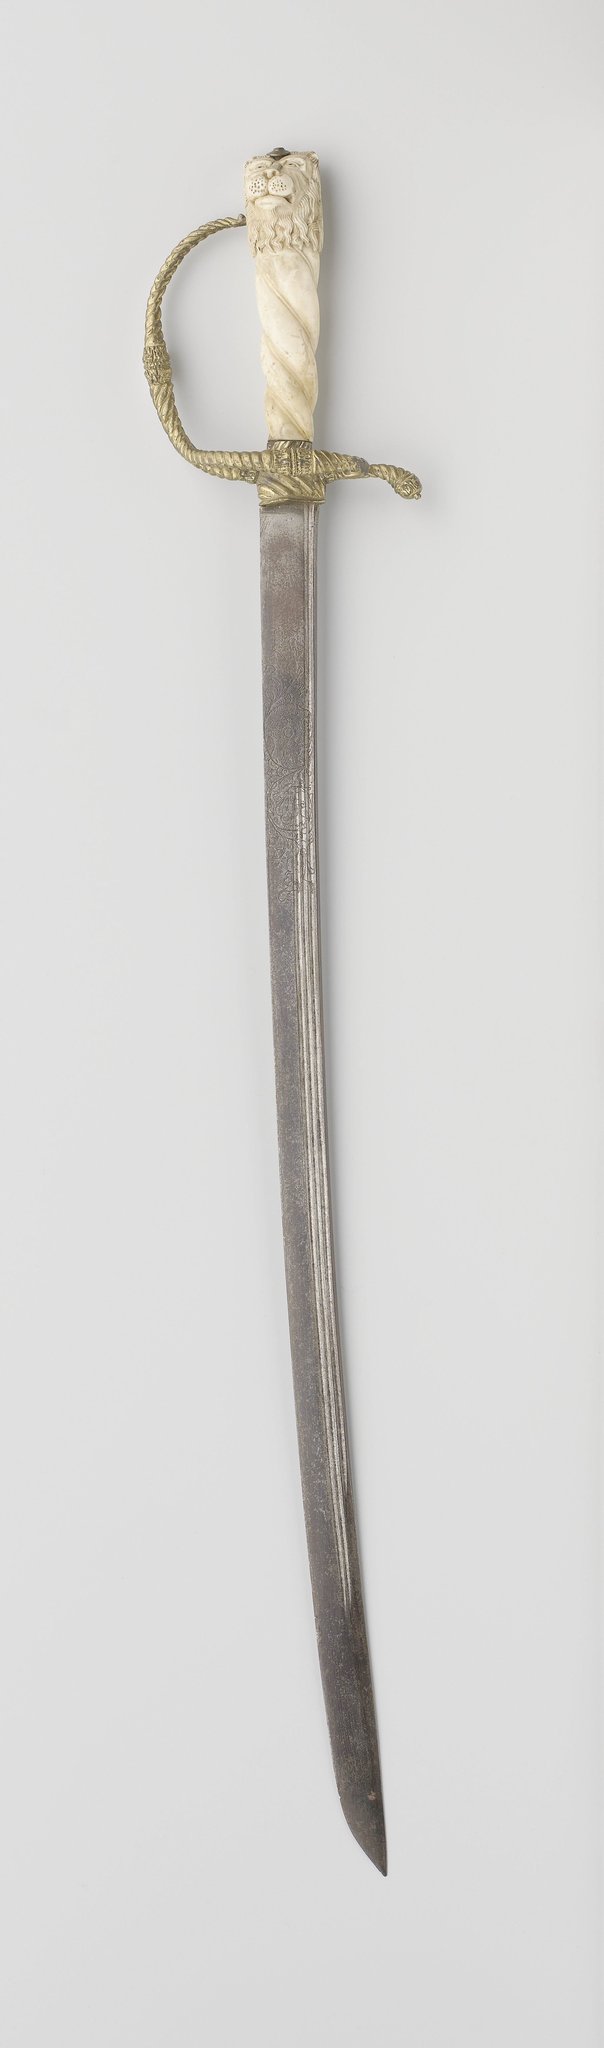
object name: sabre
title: Sabel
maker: Anonymous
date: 1600-1700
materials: brass, iron, ivory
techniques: cutting, etching, forging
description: Sabel met gevest van ivoor. Knop in de vorm van leeuwenkop en vergulde pareerstang.